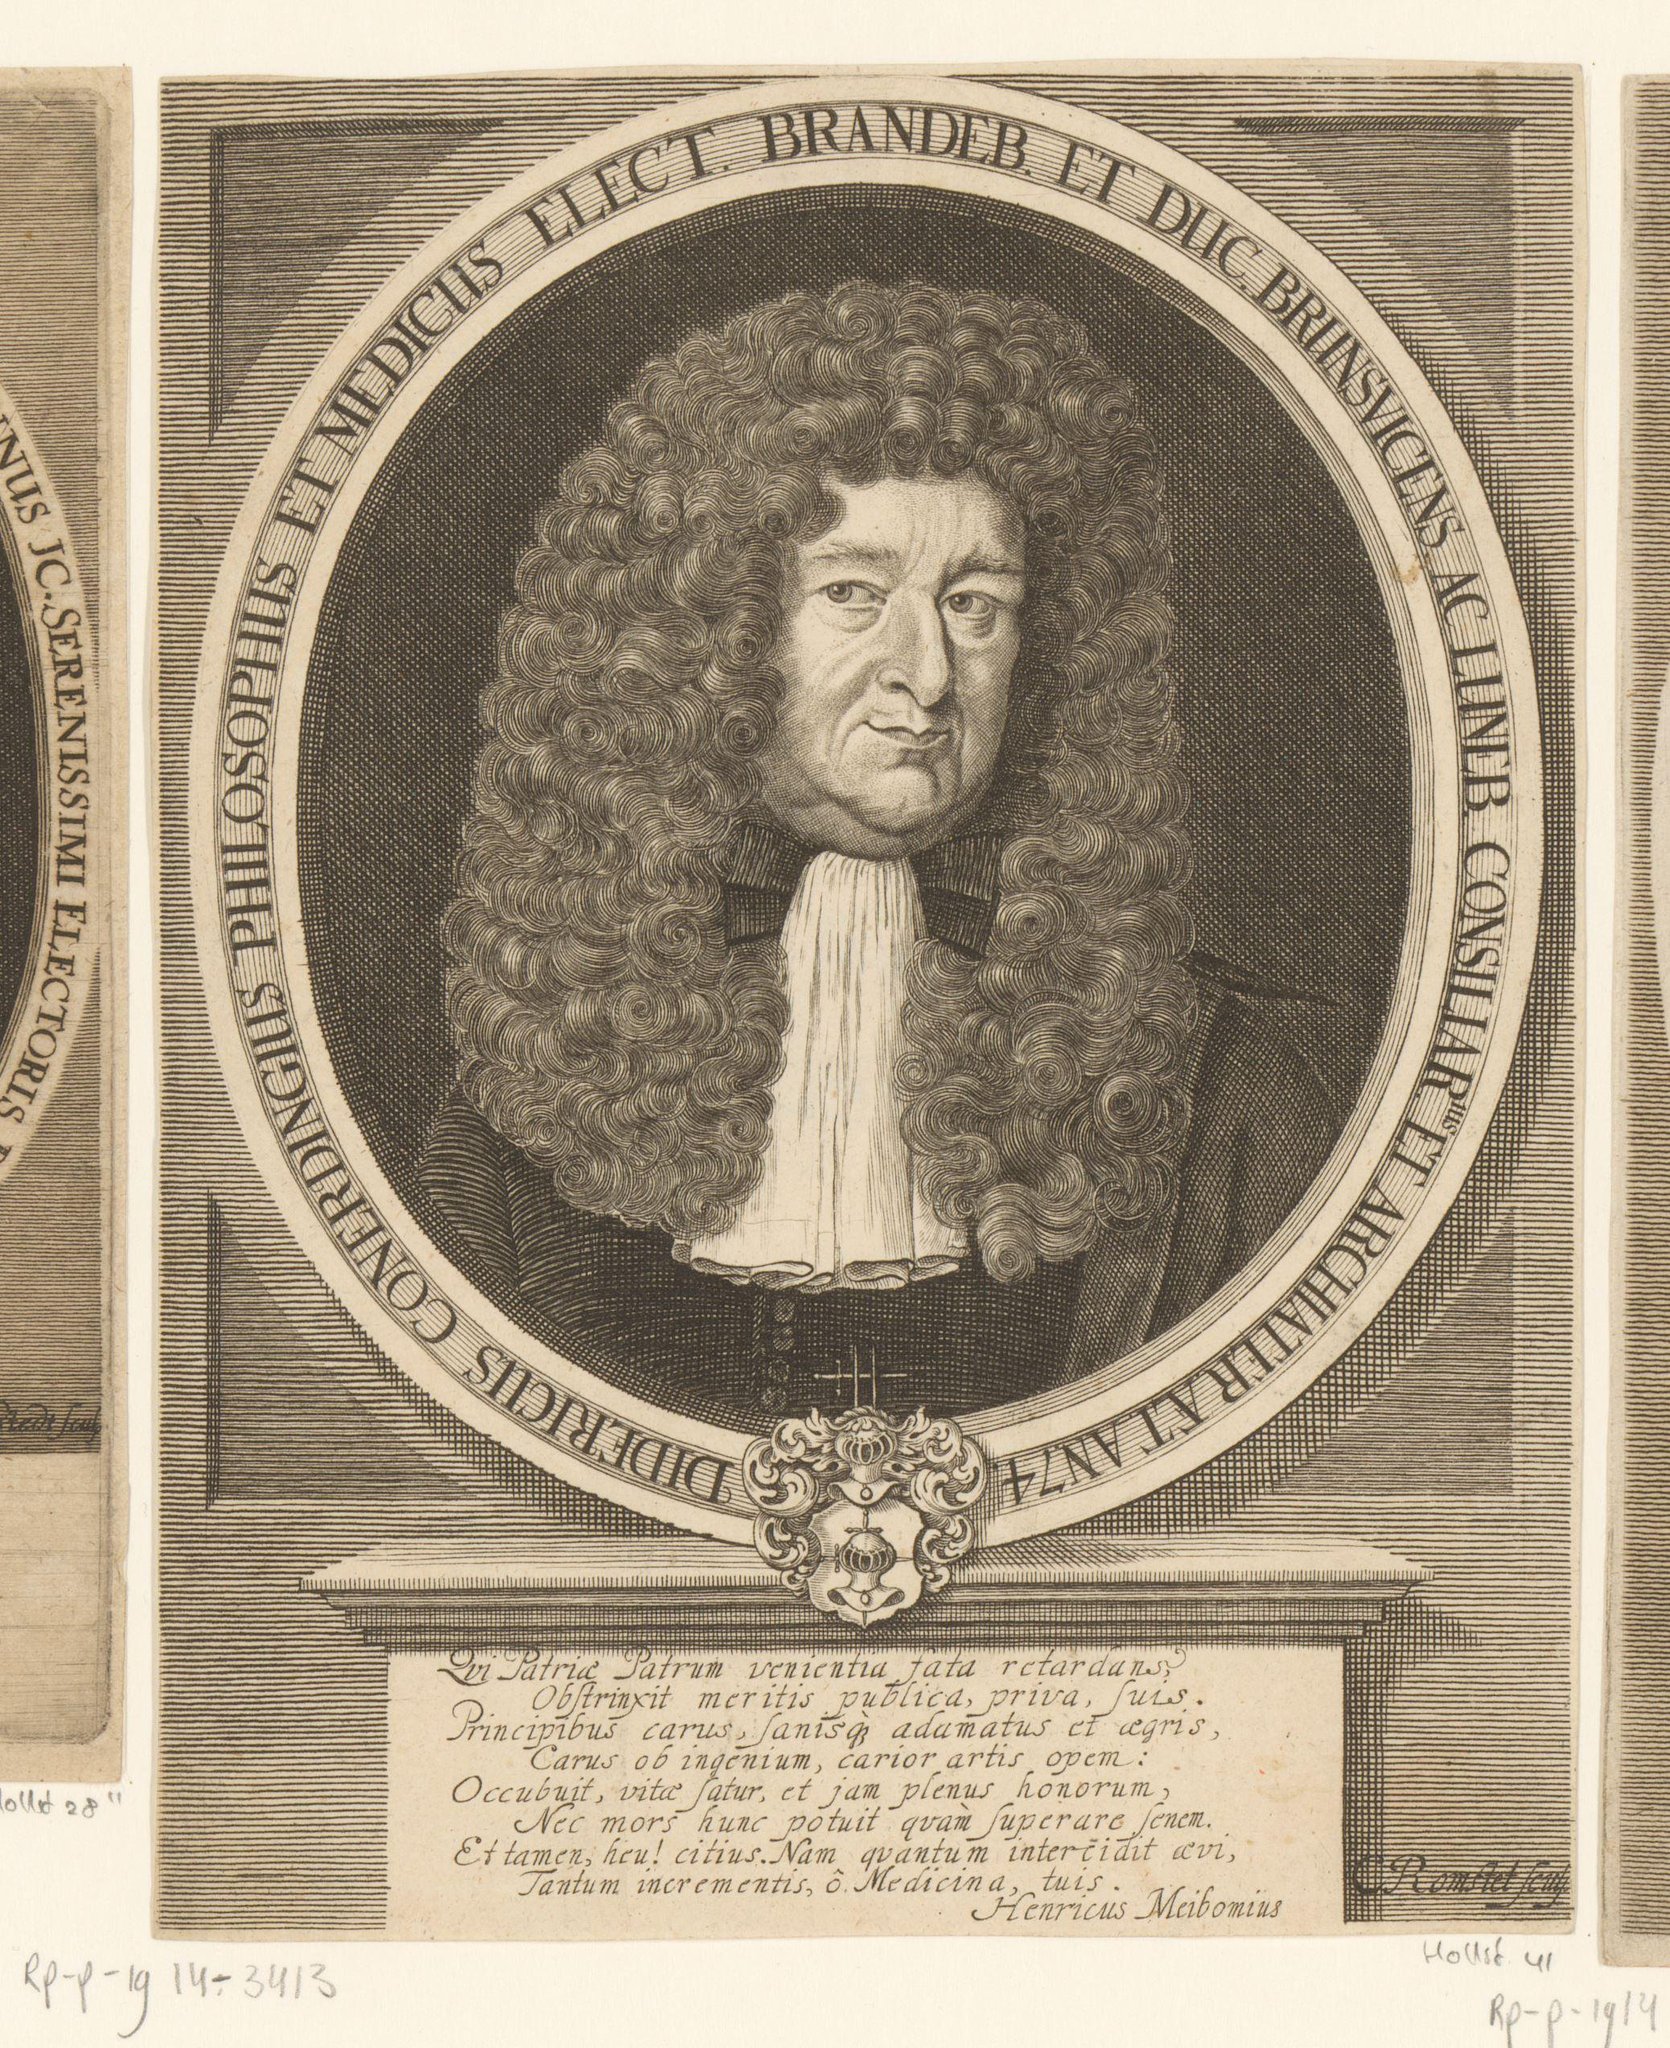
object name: print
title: Portret van Dietrich Conerding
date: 1665-1721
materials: paper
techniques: engraving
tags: historical persons, armorial bearing, heraldry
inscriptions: collector's mark: Lugt 2228